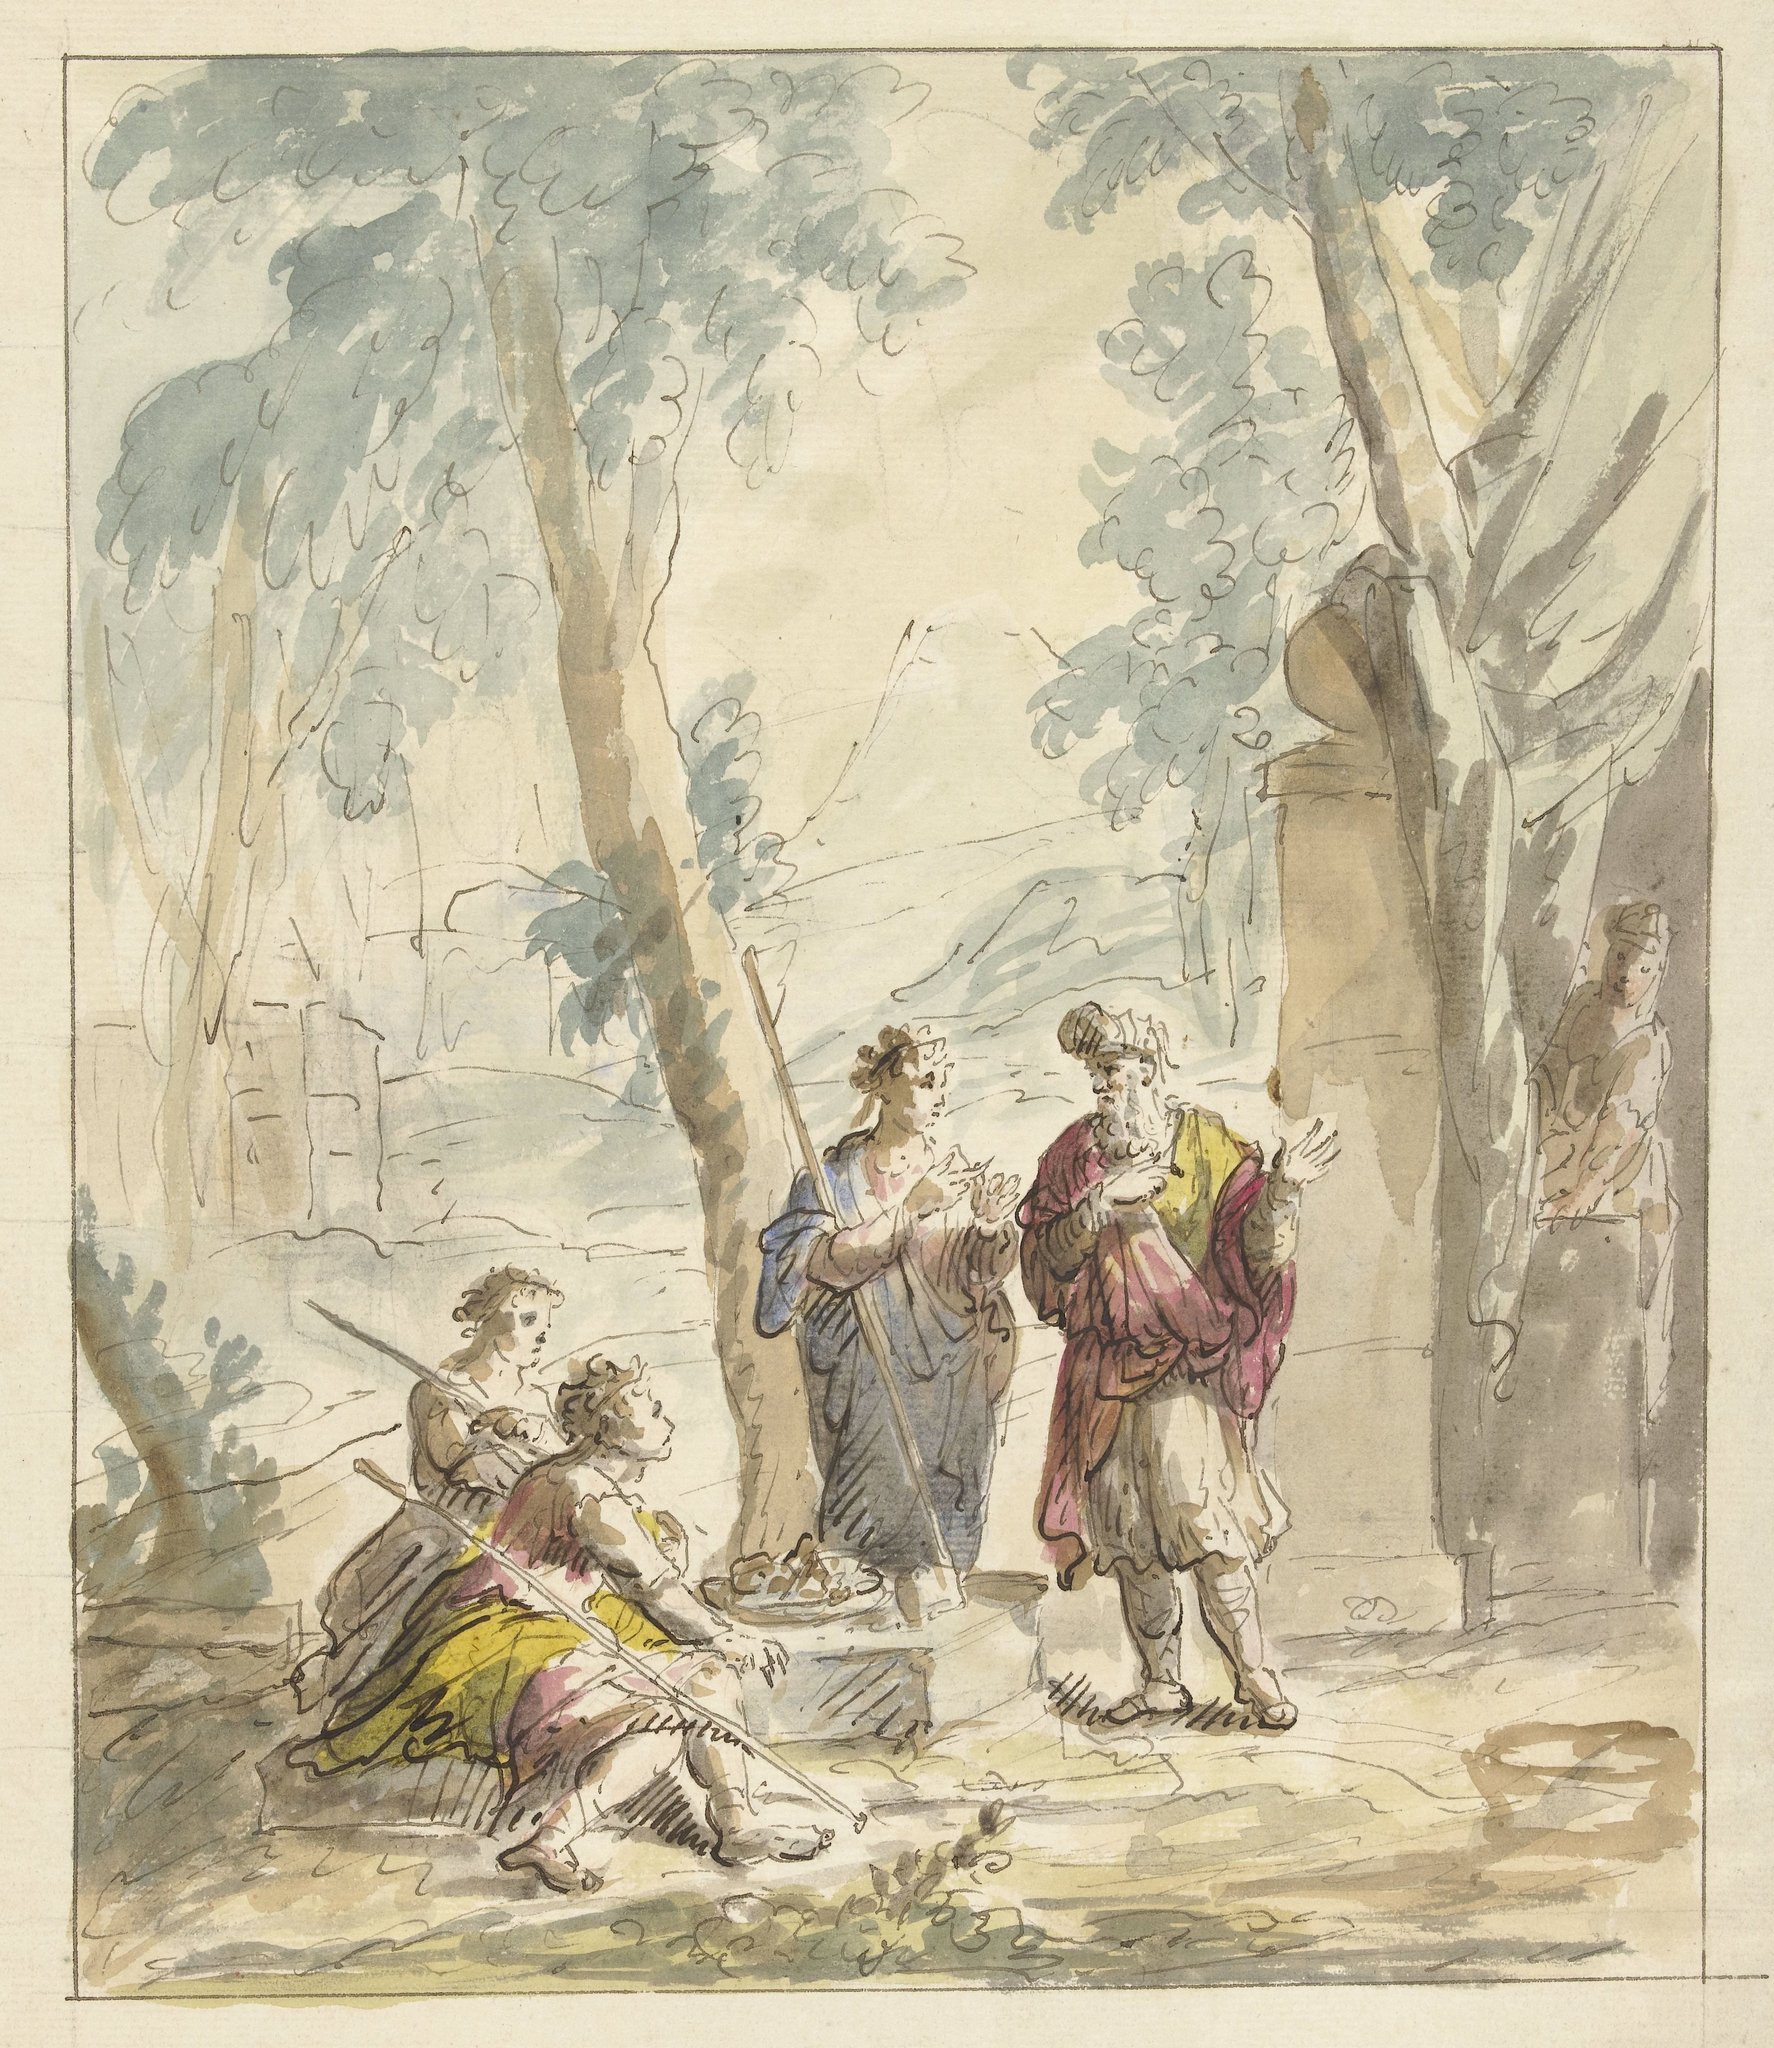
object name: drawing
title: Abraham ontvangt de drie engelen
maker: elias van nijmegen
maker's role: draughtsman, painter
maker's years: 1667-1755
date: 1677-1755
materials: ink, paper, pencil, watercolor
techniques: brush, pen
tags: abraham entertaining the three angels